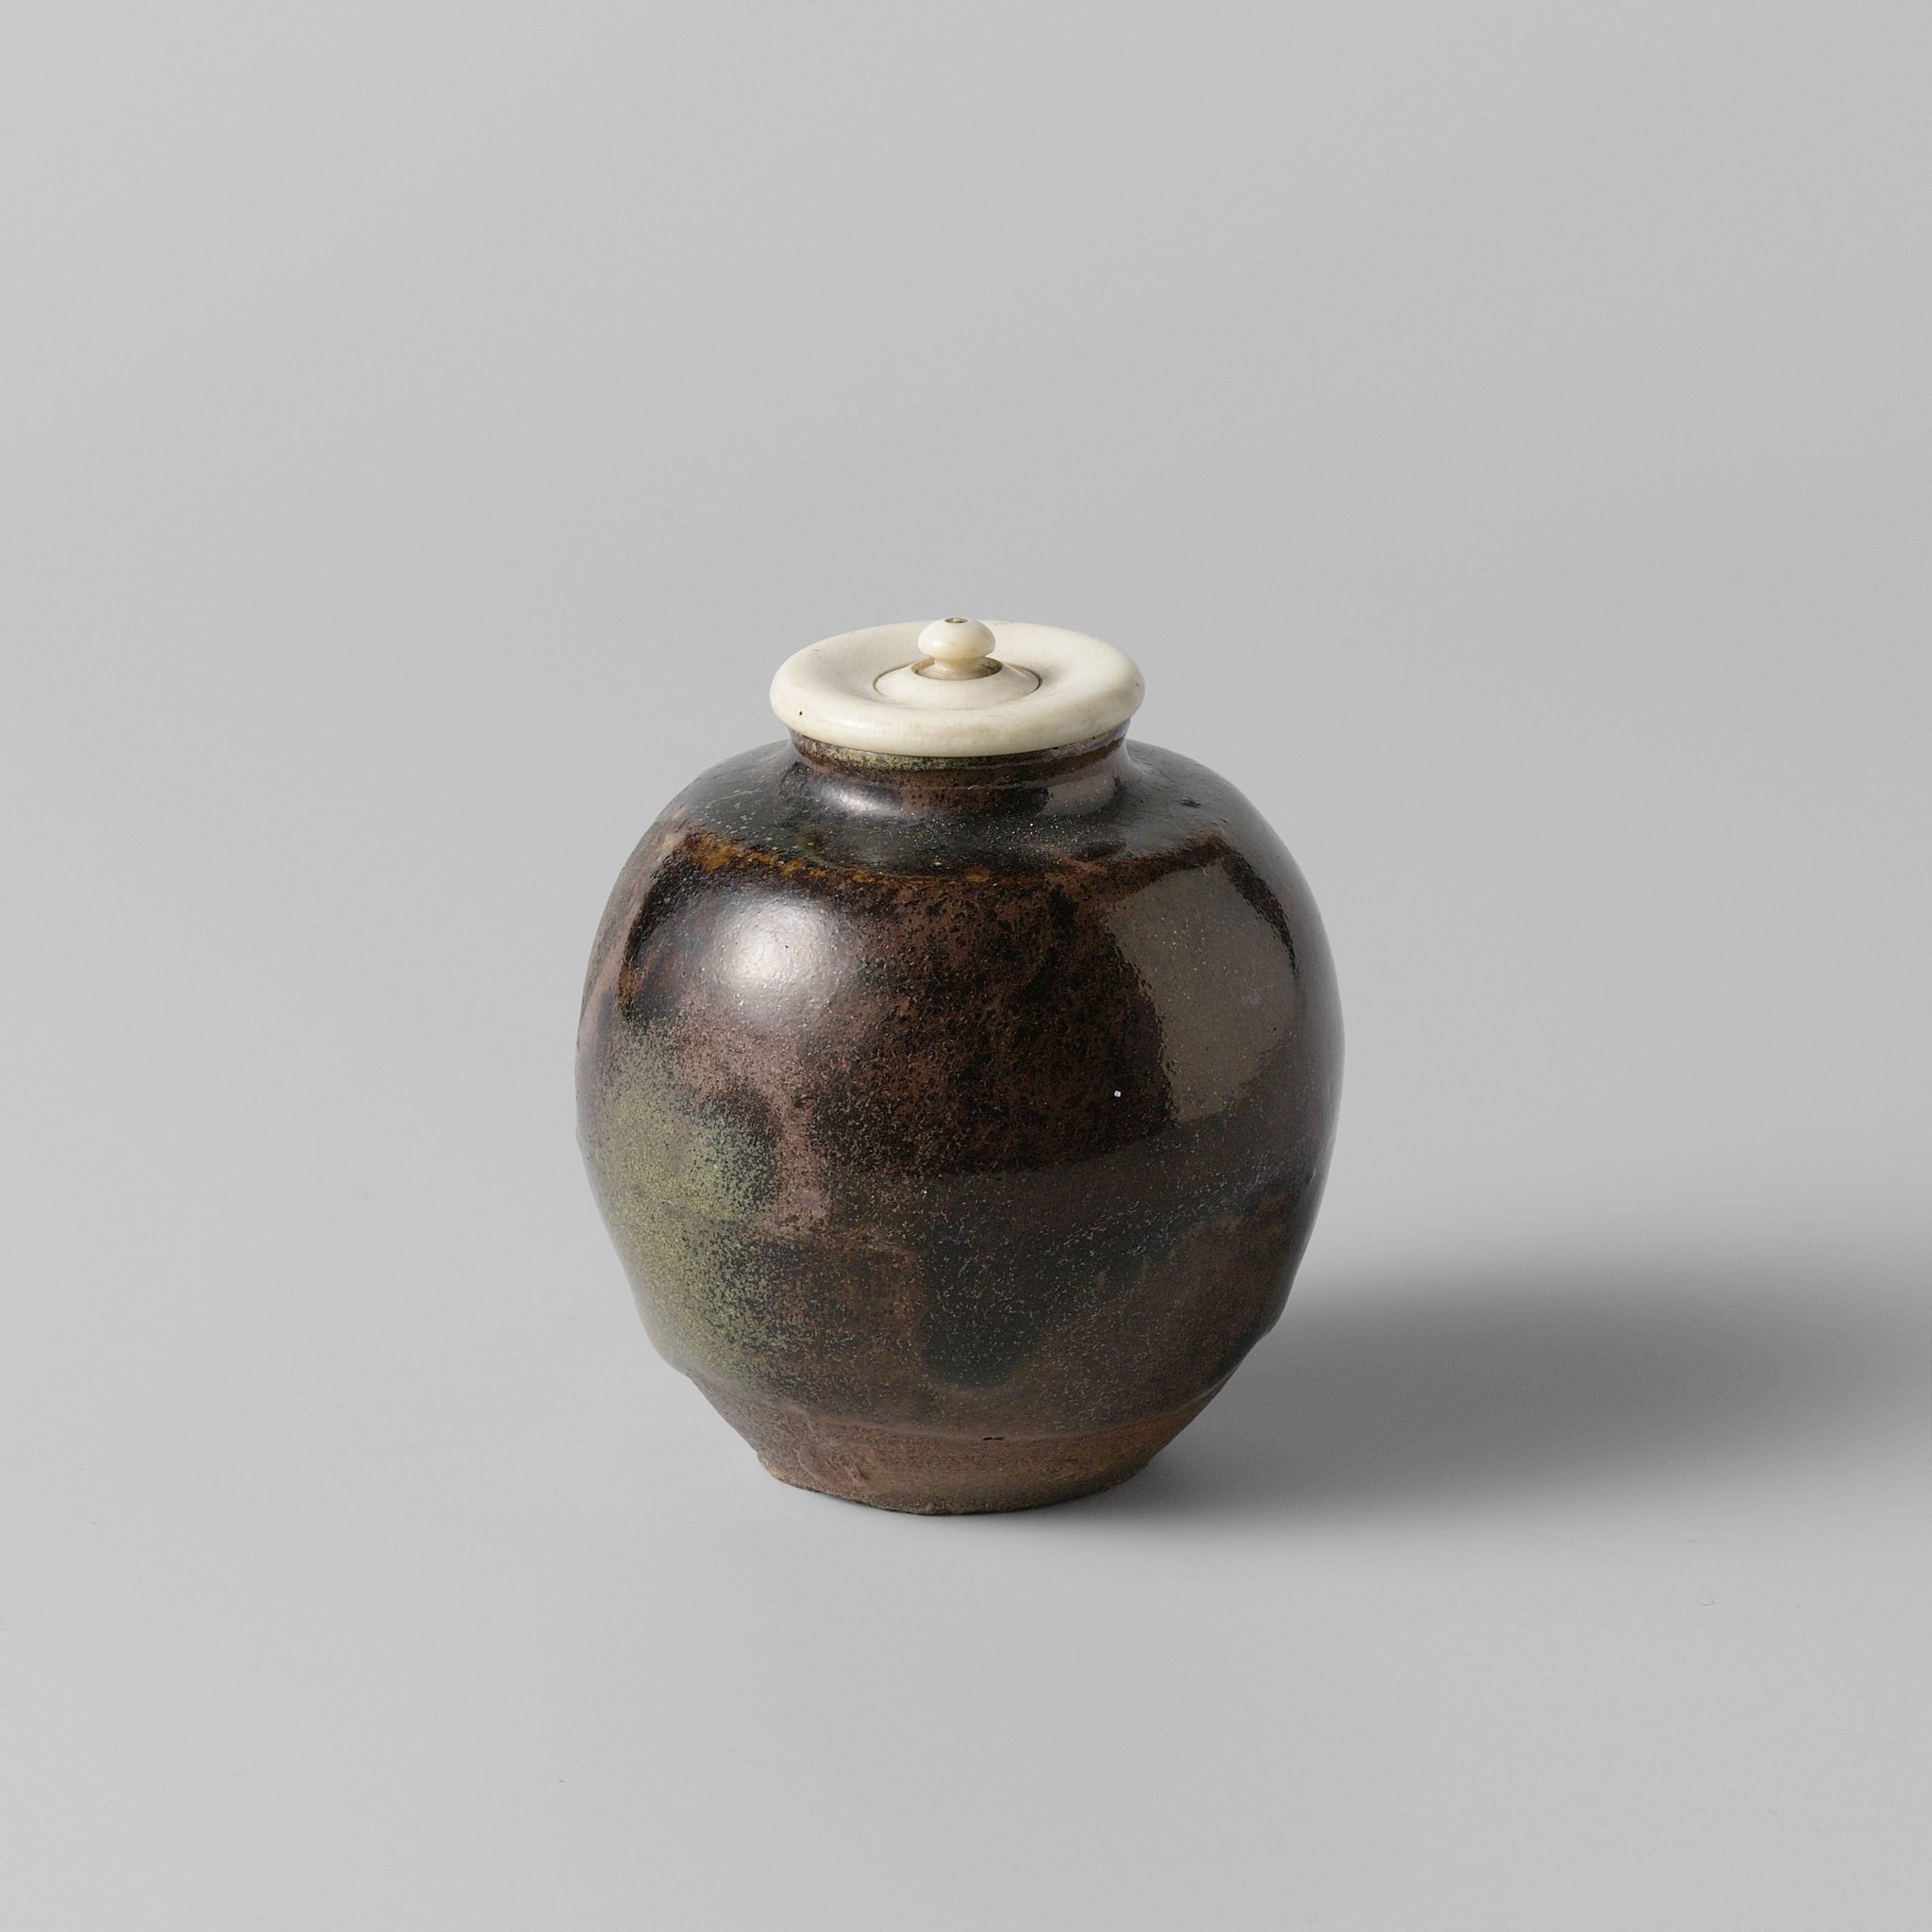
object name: stoftheebus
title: Tea caddy with a green brown glaze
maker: Anonymous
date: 1800-1899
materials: glaze, ivory, stoneware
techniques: firing, turning, vitrification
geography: agano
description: Stoftheebus of chaire van steengoed met een ivoren deksel, gedeeltelijk bedekt met een groenbruin glazuur. De onderzijde van de bus is ongeglazuurd. Oud label aan de binnenzijde met 'Agano/ 18e'. Agano.